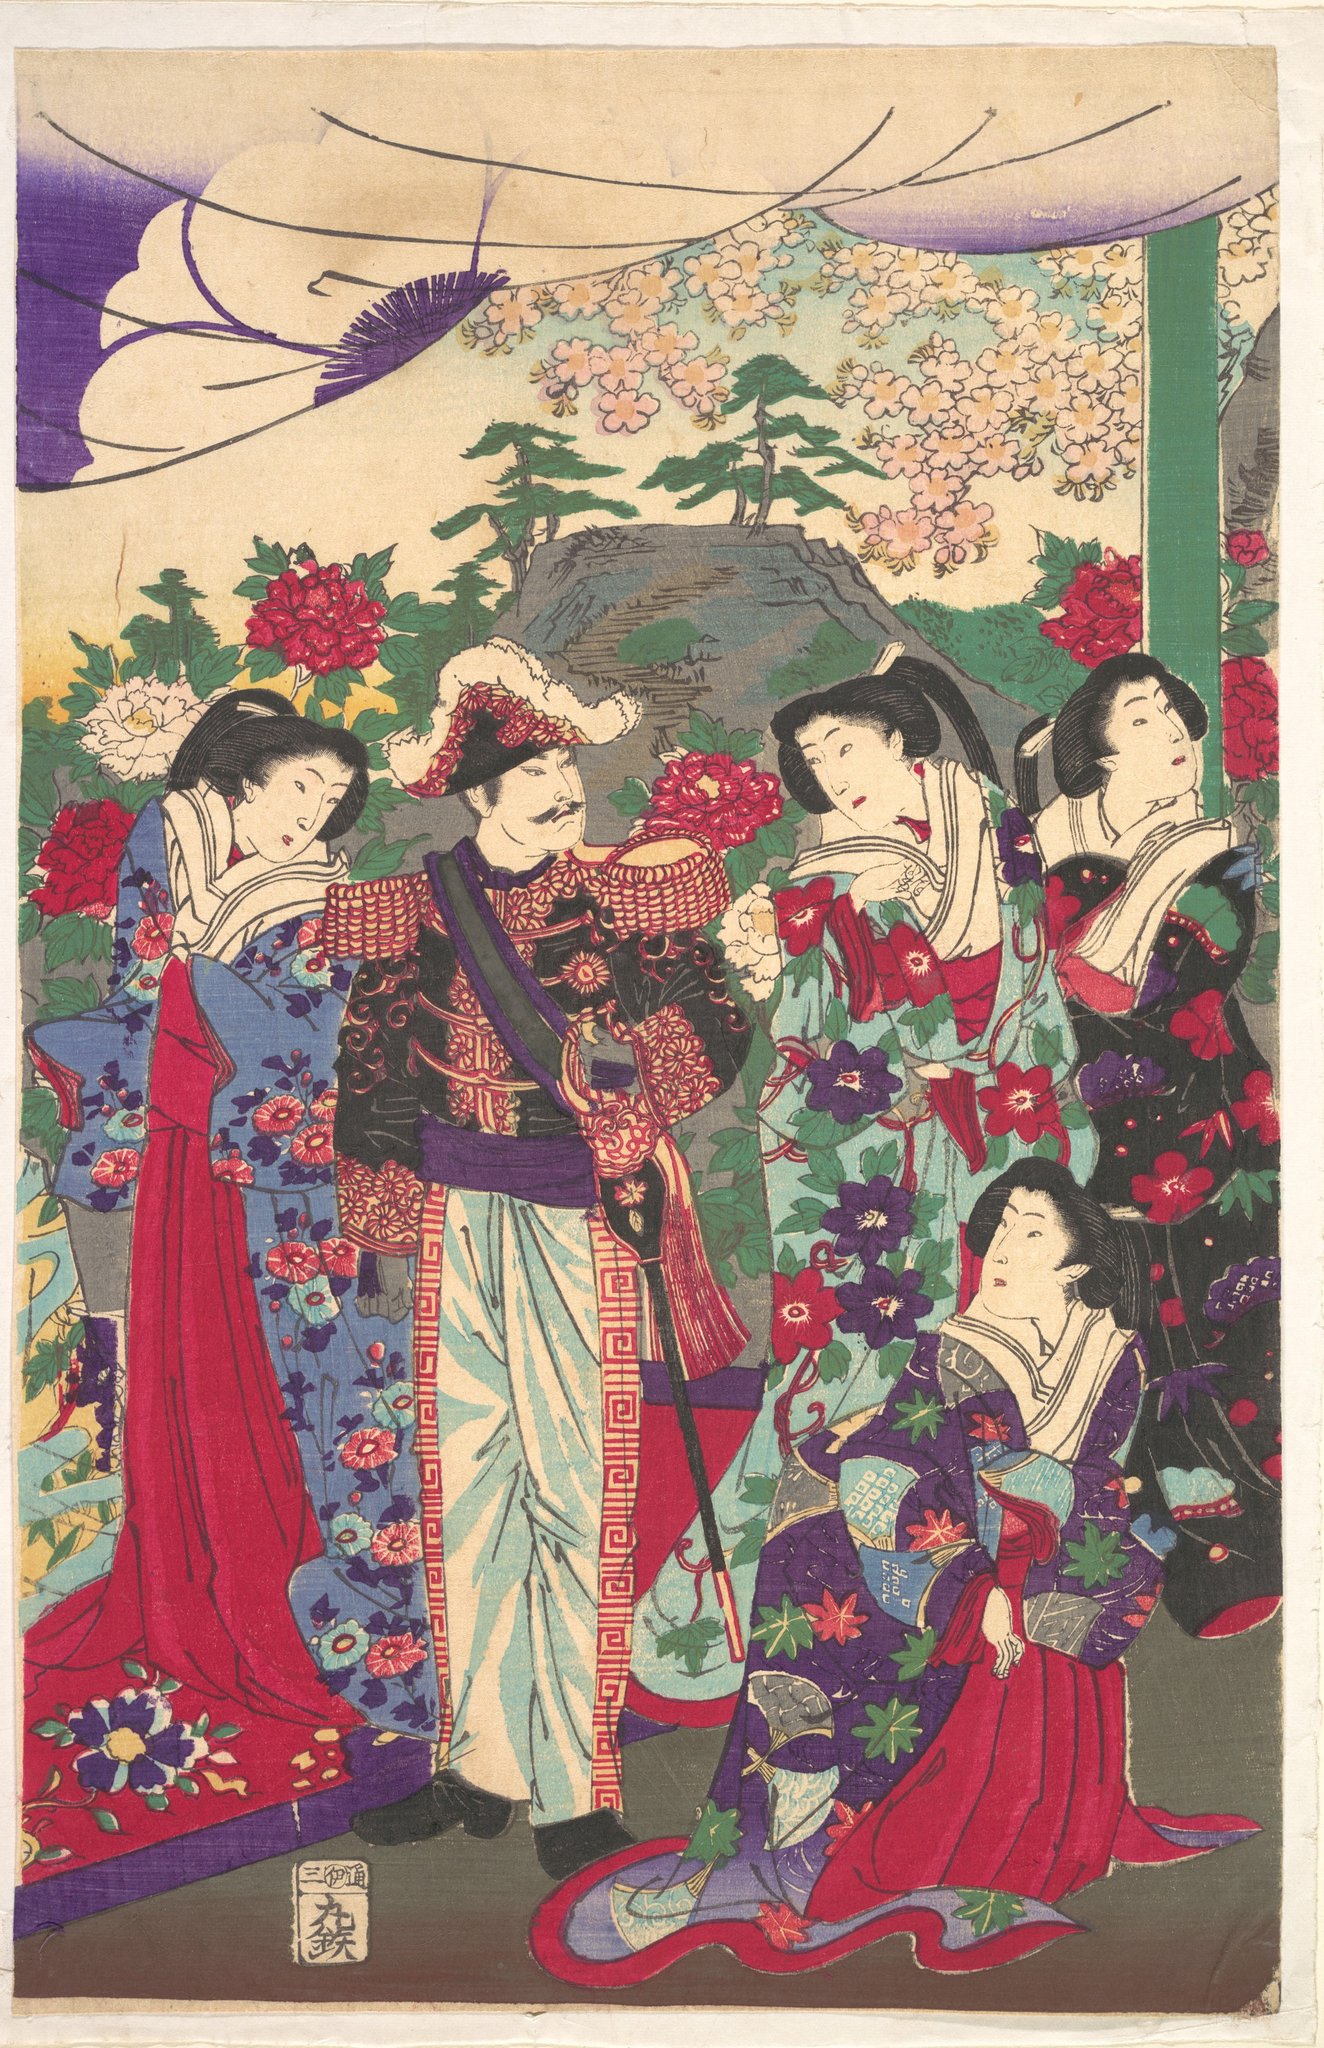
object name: print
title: Emperor among Court Ladies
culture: japanese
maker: yōshū (hashimoto) chikanobu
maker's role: artist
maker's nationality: japanese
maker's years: 1838-1912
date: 1880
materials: ink, paper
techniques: woodblock print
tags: swords,kings,women,flowers